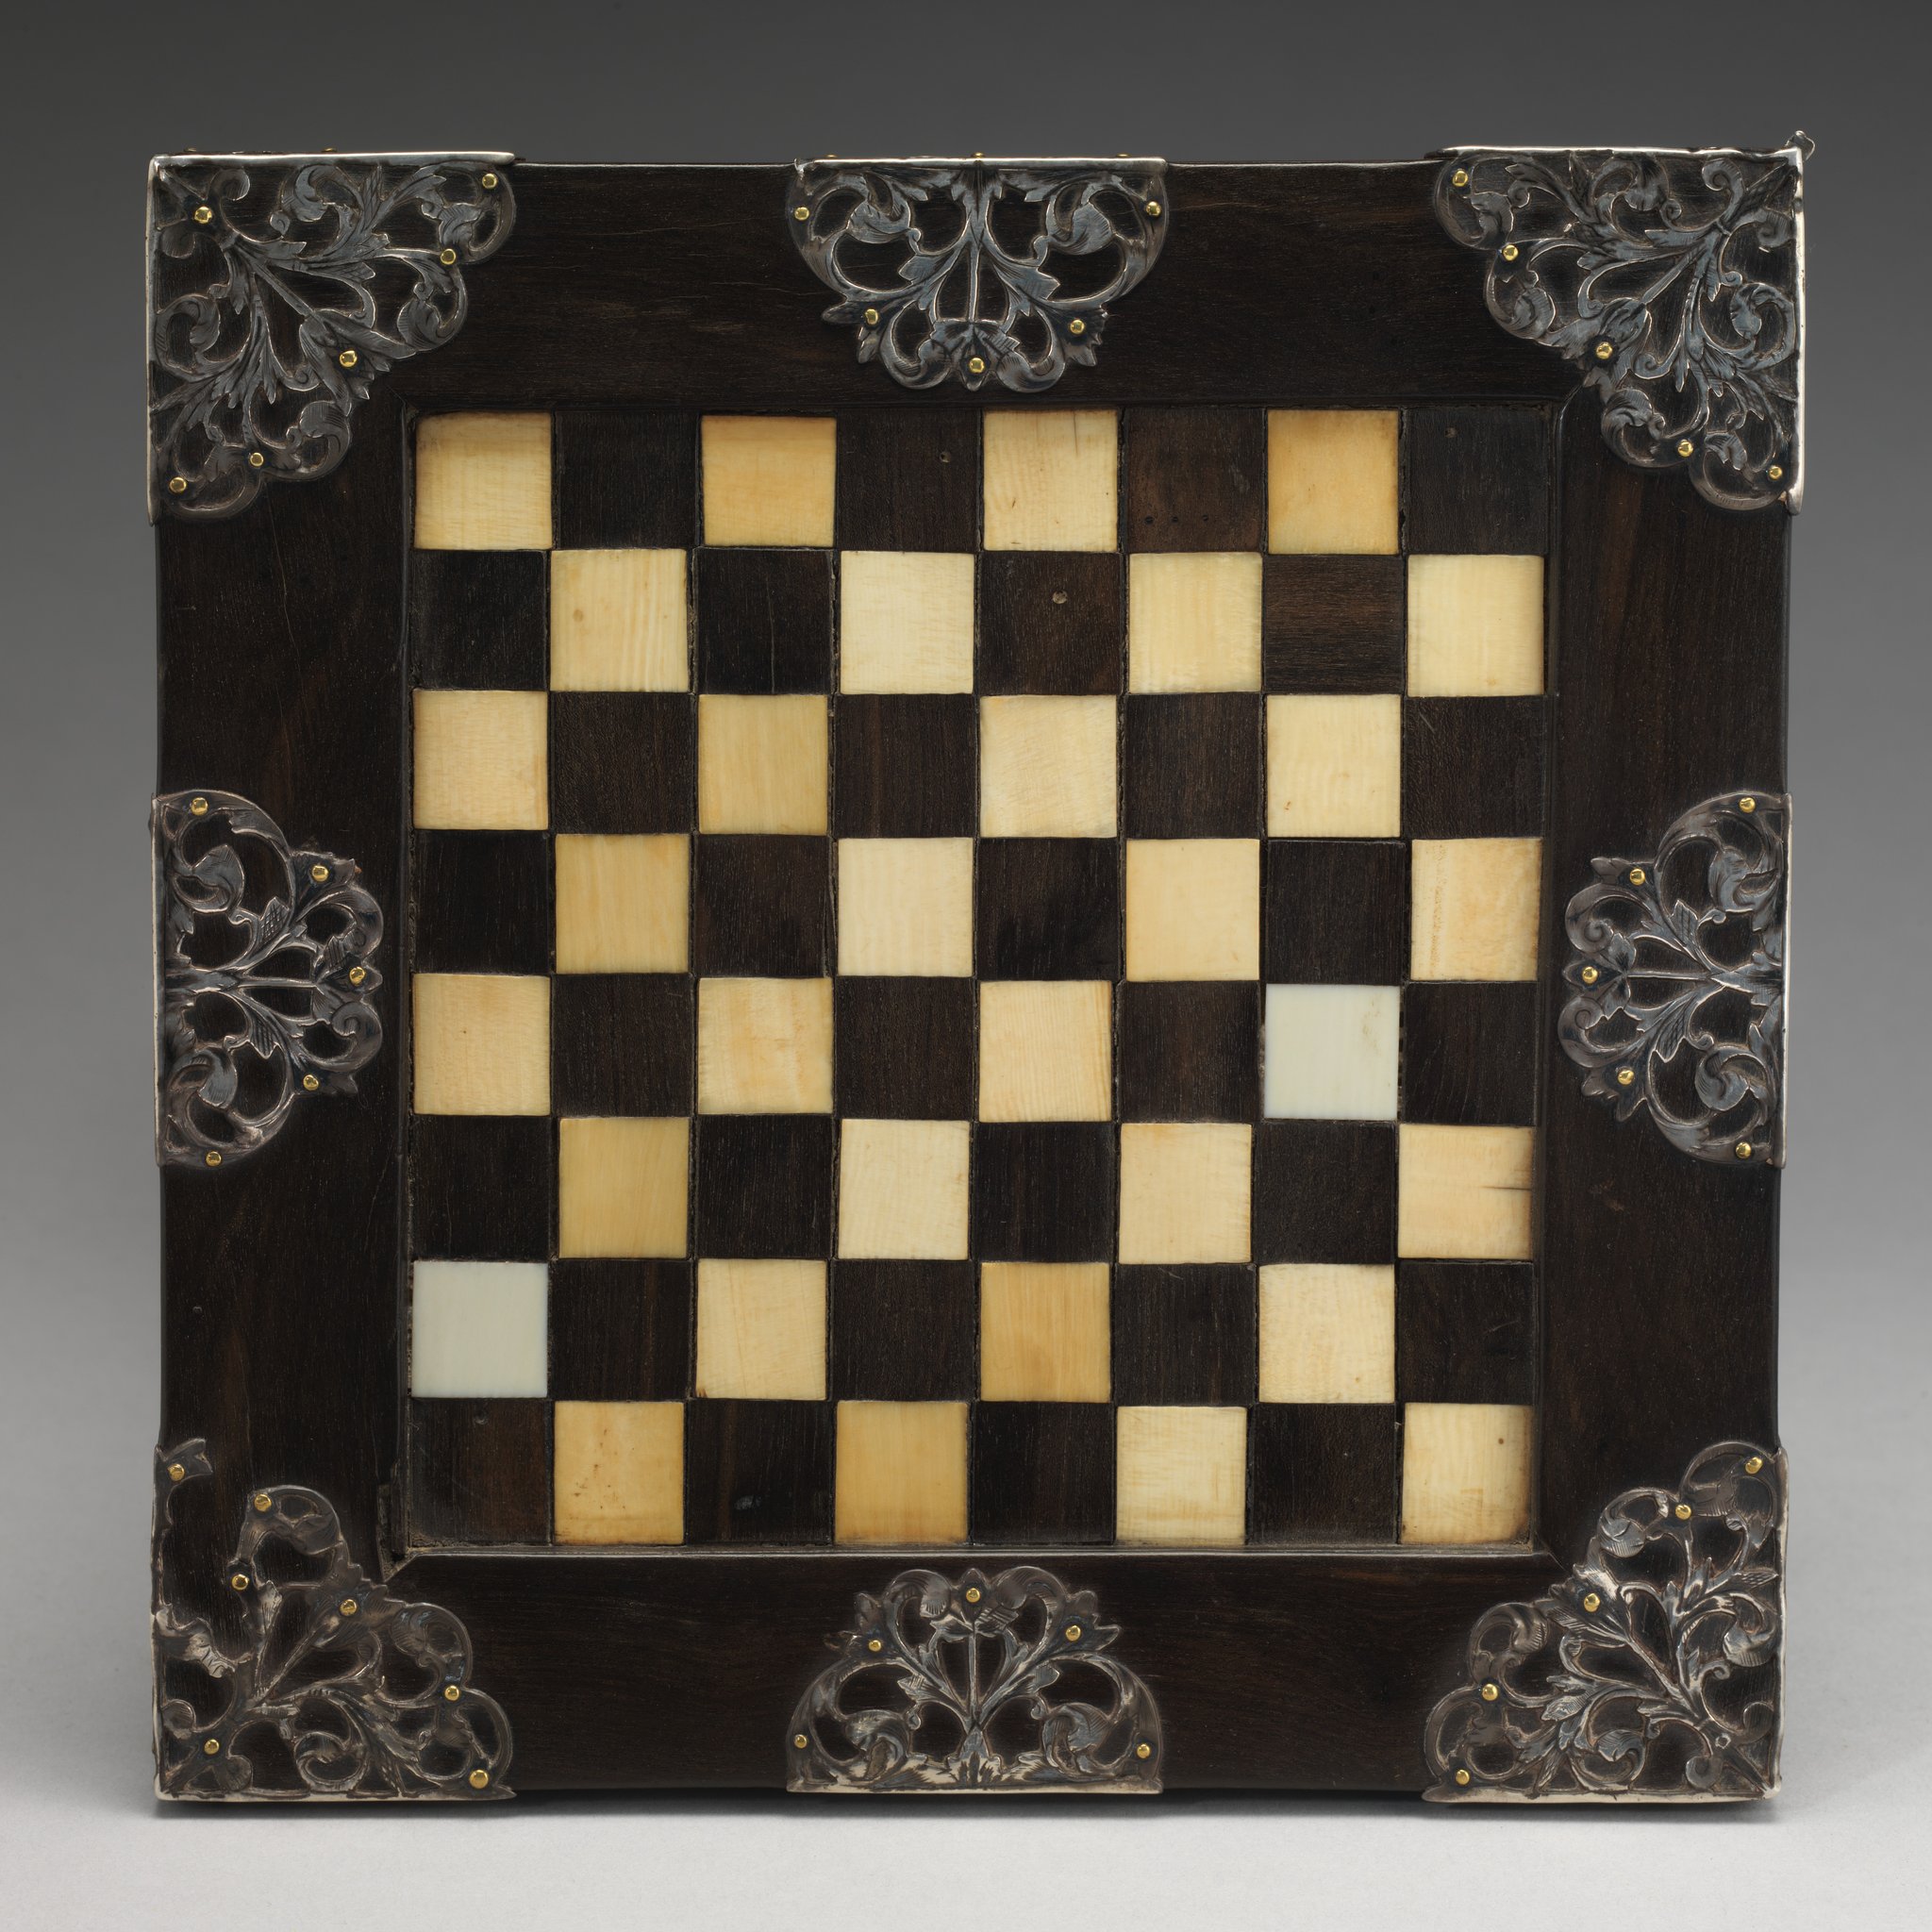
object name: chessboard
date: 1651-1675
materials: wood, ivory, silver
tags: chess